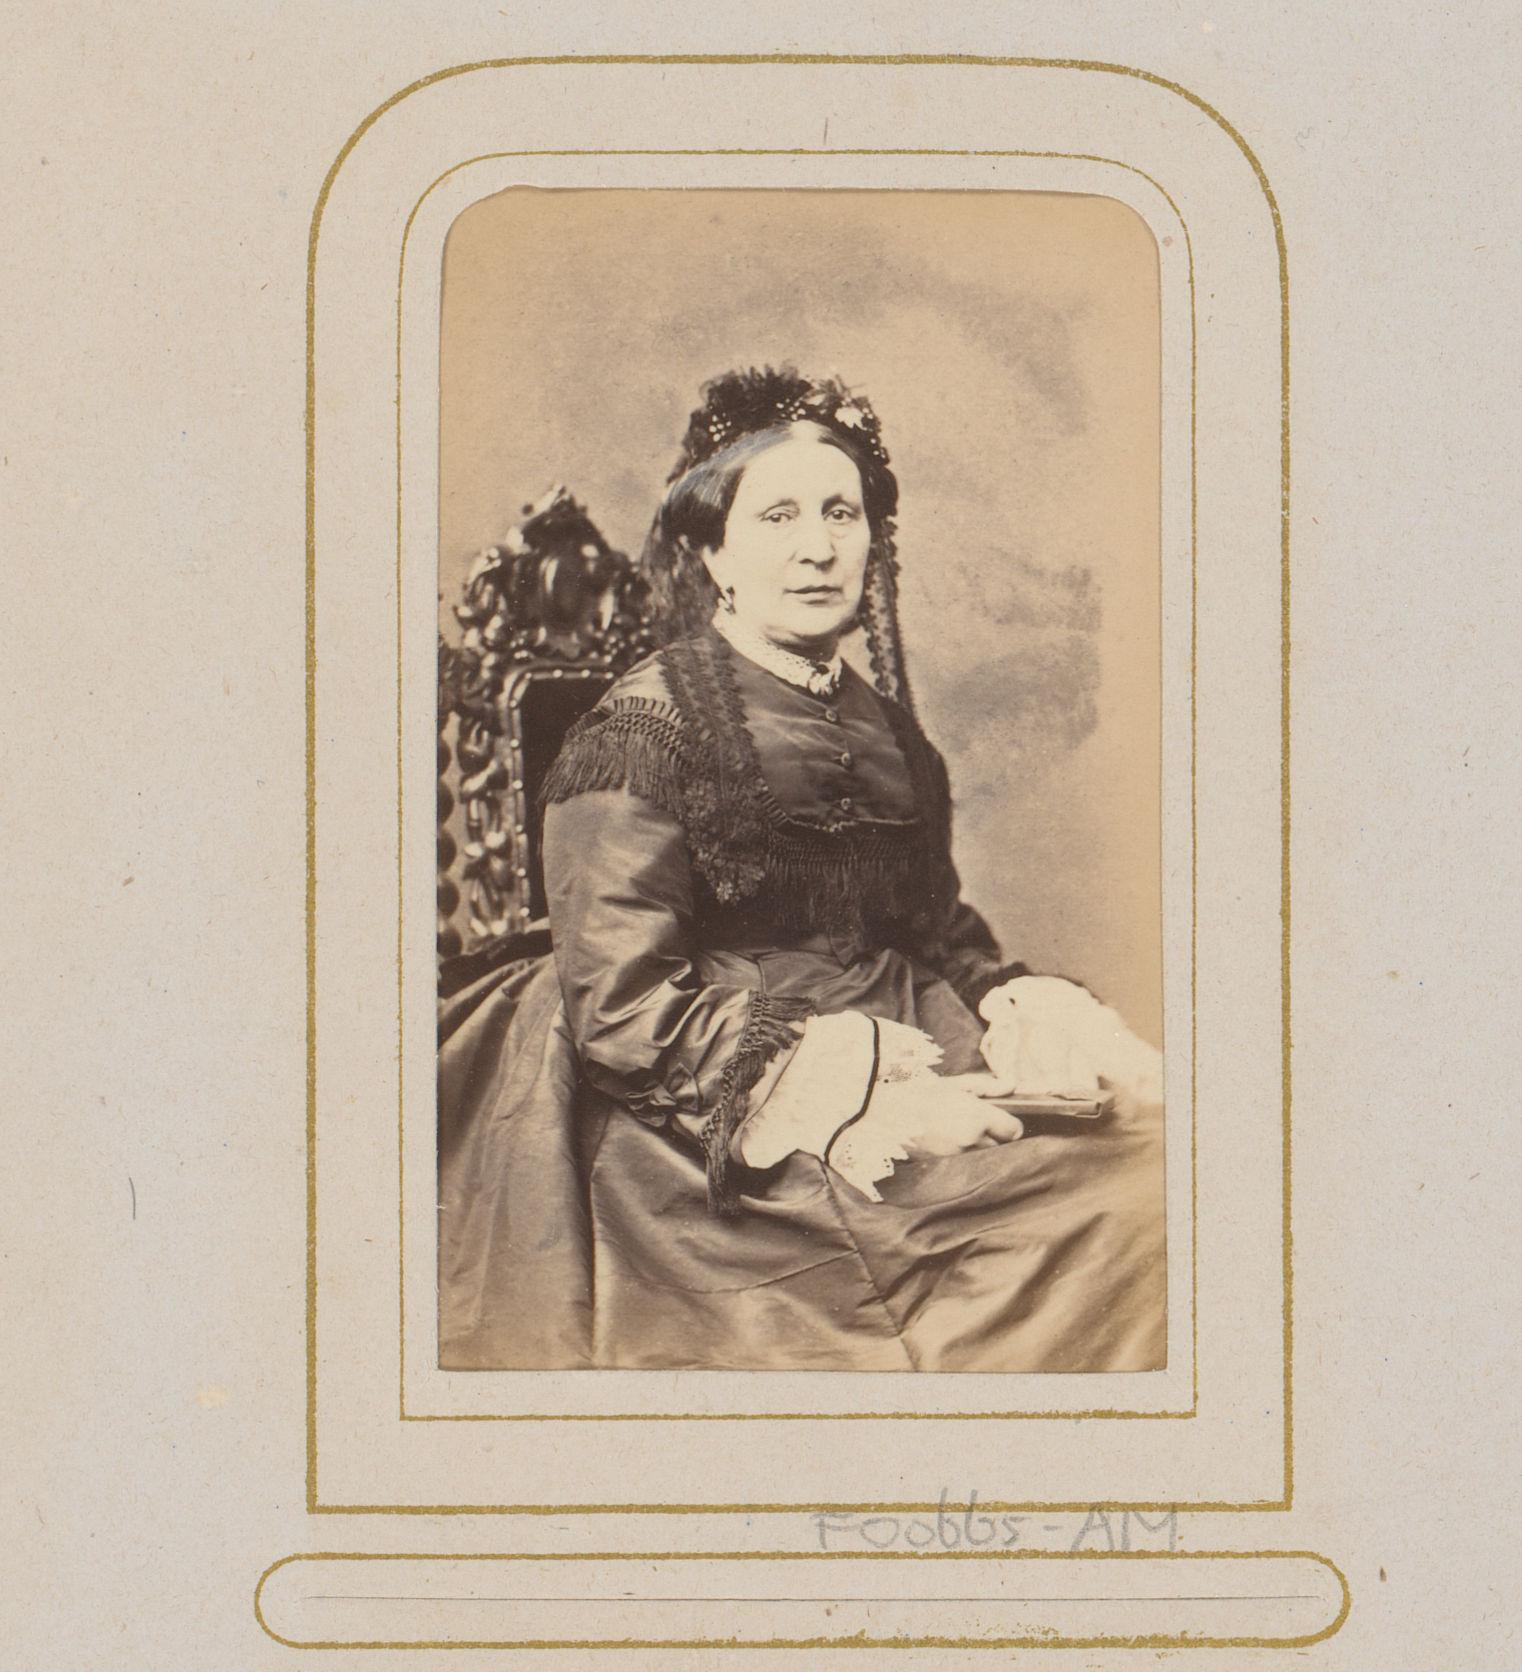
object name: photograph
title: Portret oude vrouw met muts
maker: carel eduard westerborg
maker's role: fotograaf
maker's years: 1842-1916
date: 1861-1880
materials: cardboard, photographic support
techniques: albumen print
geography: arnhem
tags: historical persons - bb - woman, head-gear: cap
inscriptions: inscription: ‘C.E. Westerborg/ Photograaf/ B.263. Vossenstraat B 263/ Arnhem’